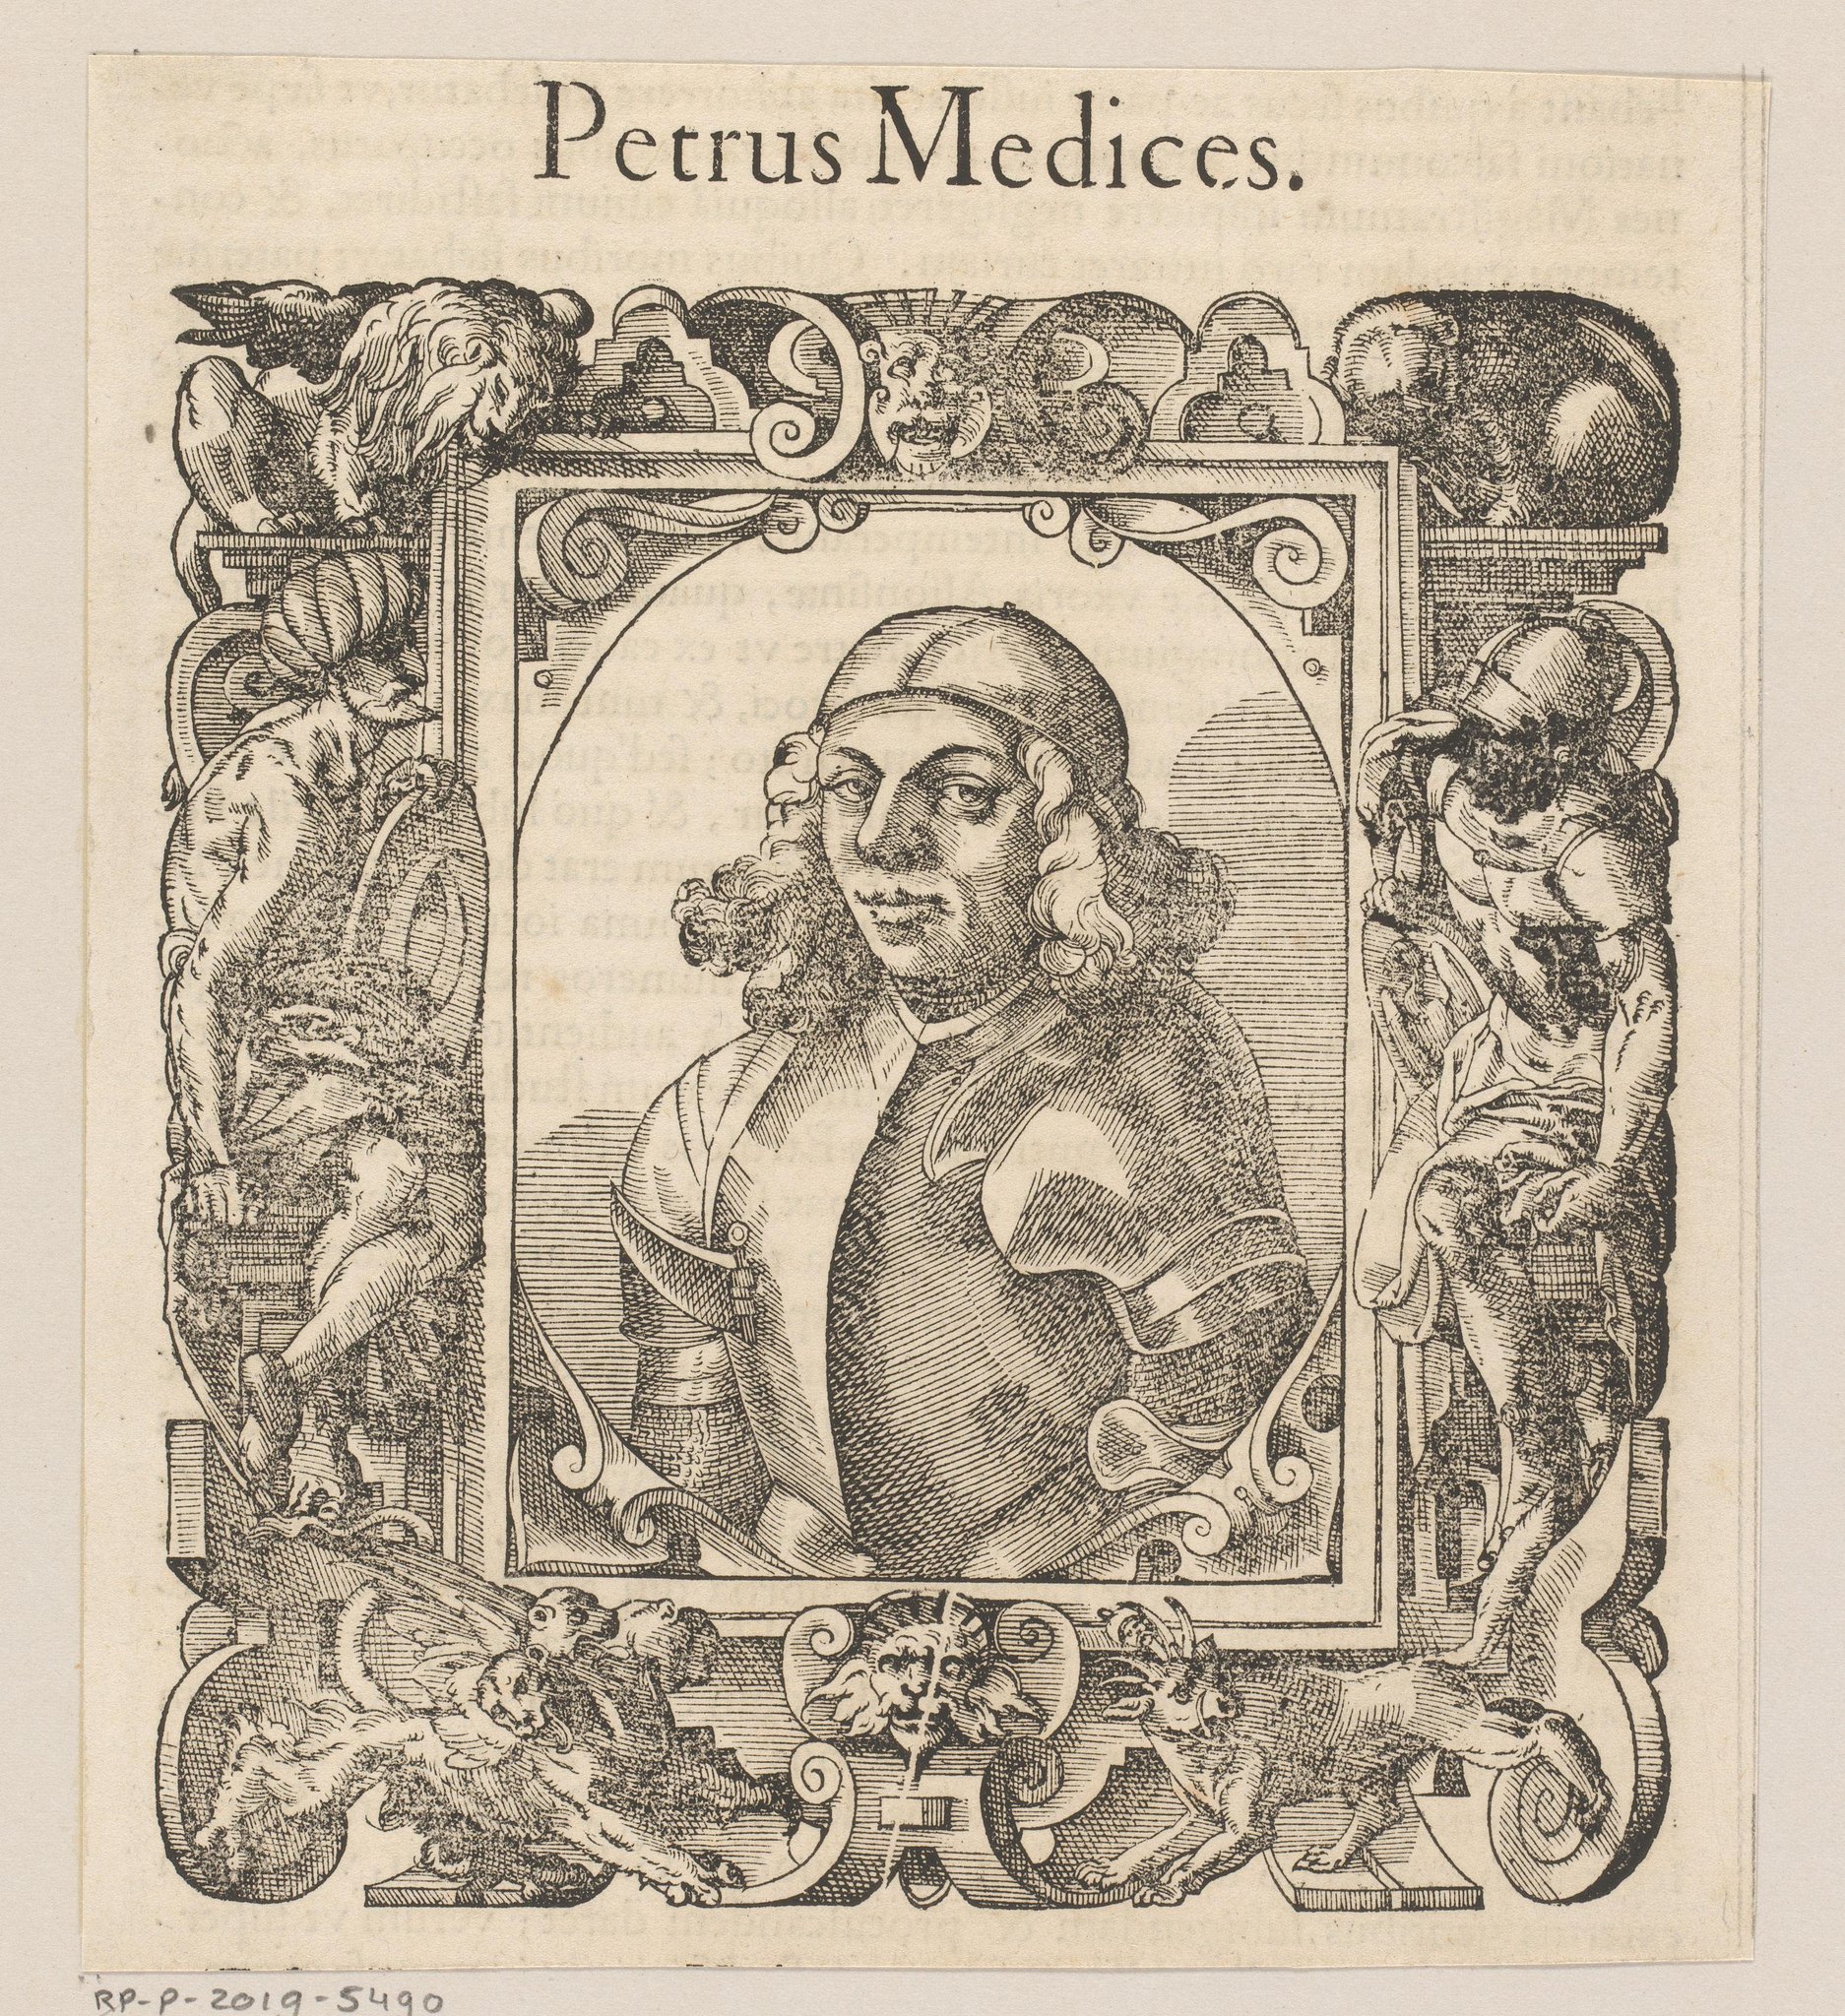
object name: print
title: Portret van Piero di Lorenzo de' Medici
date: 1575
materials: paper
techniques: letterpress printing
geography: basel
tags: armour, historical persons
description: Prent uit: Giovio, Paolo. Elogia virorum bellica virtute illustrium (...). Bazel: Peter Perna, 1575, p. 187. Prent ook gebruikt in latere publicaties.